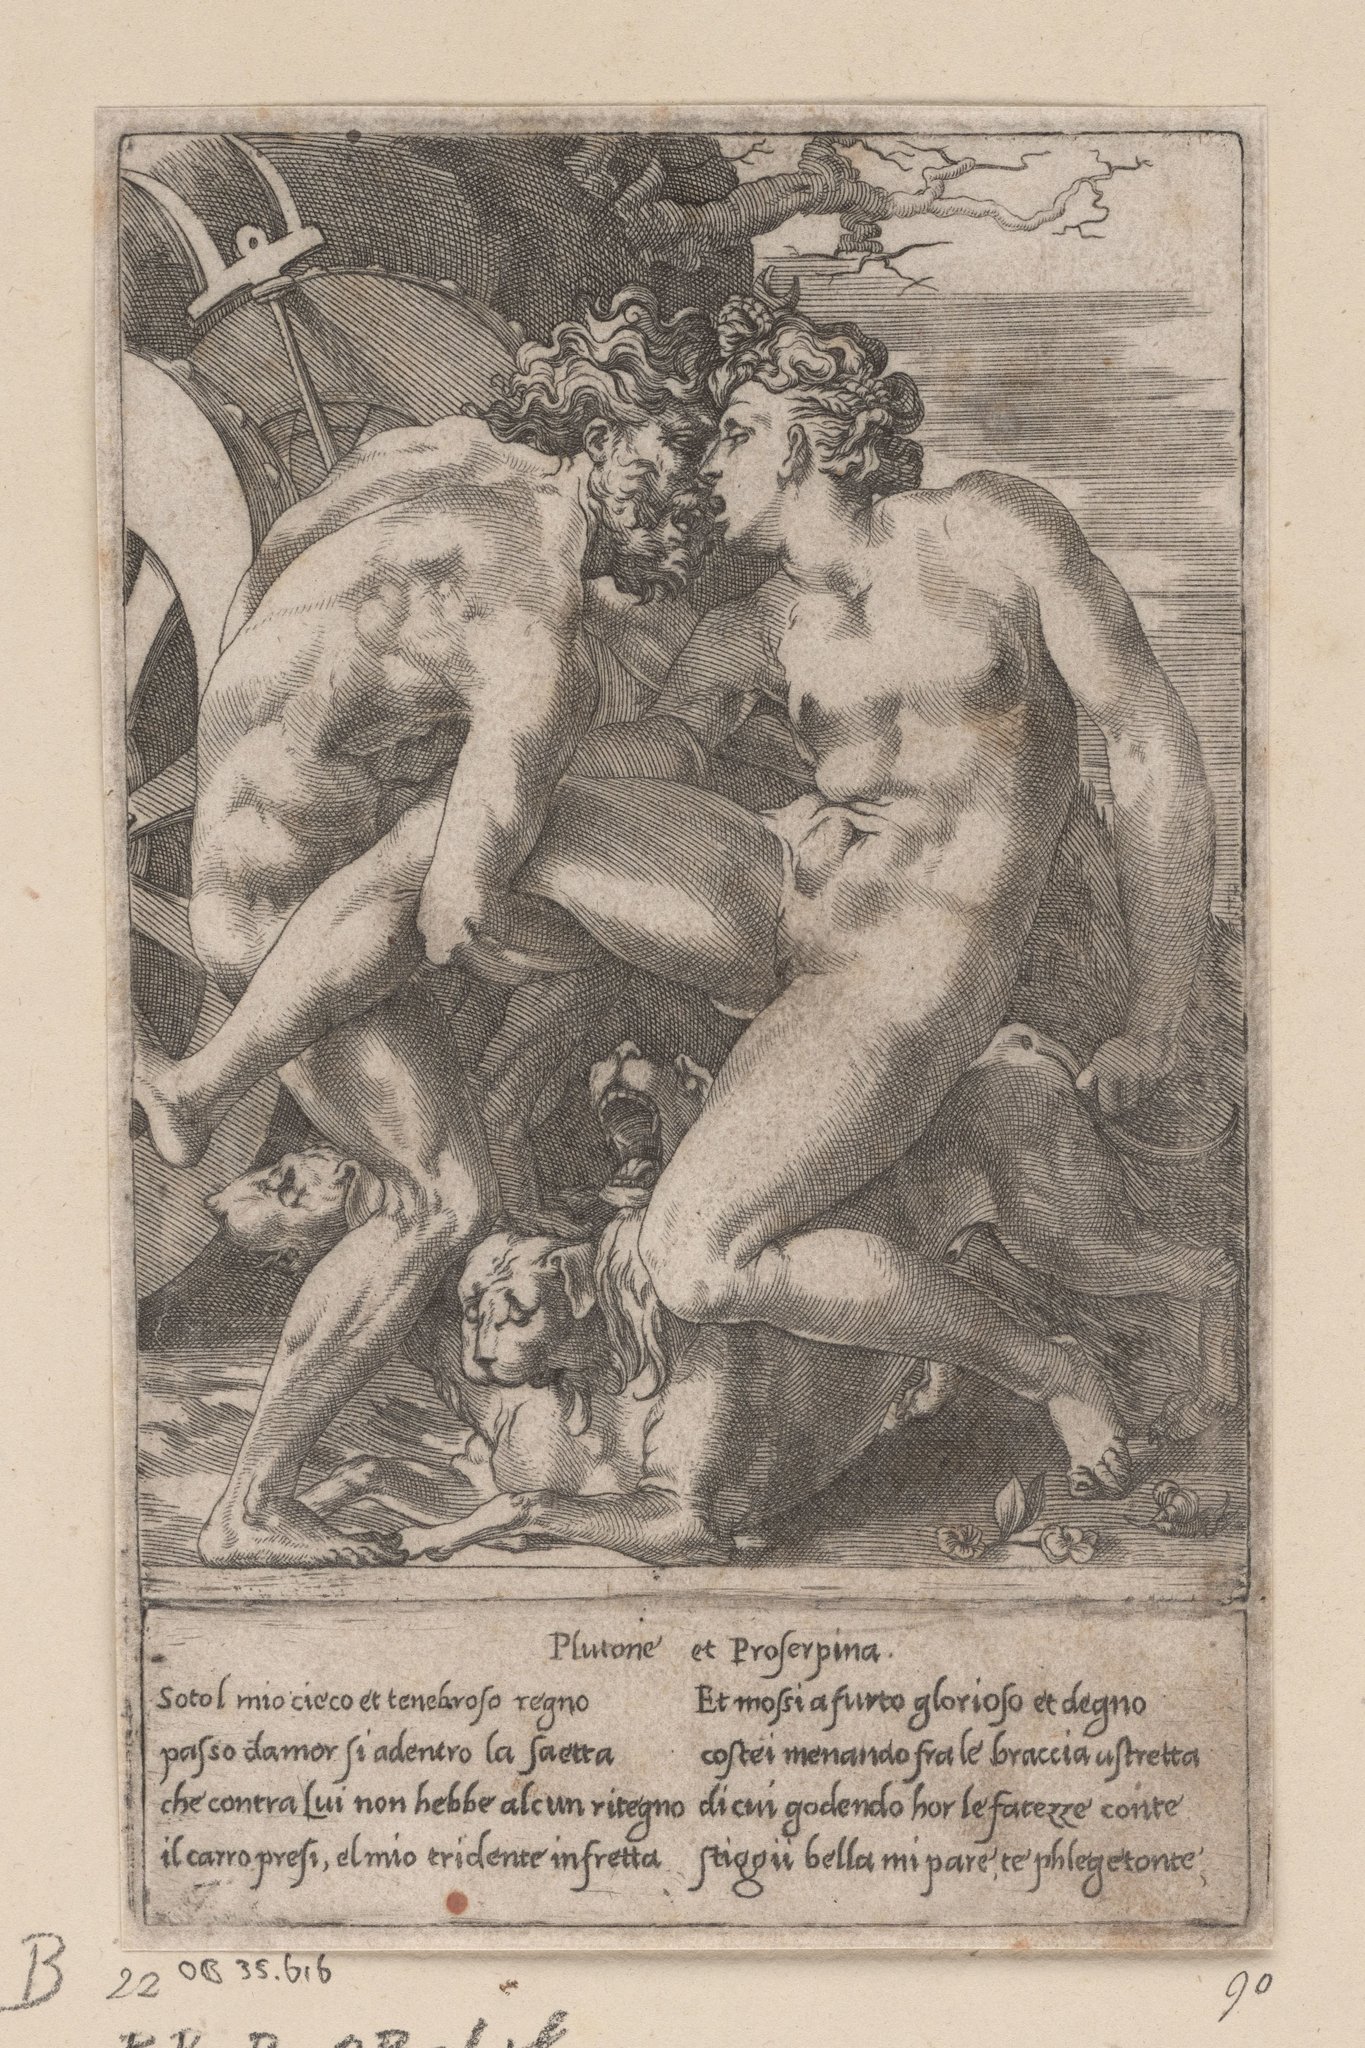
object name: print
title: Loves of the Gods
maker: giovanni jacopo caraglio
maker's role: goldsmith, print maker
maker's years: 1500-1565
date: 1515-1565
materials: paper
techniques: engraving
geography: italy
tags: love-affairs of pluto, pluto in love with proserpina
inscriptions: collector's mark: Lugt 240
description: No collection of erotic prints should be without Caraglio’s Loves of the Gods. Consisting of twenty-some prints, this scandalous series presents the amorous escapades of the classical gods fairly explicitly. The deities give in to pure lust with great abandon, which involves quite some acrobatic feats. These scenes will doubtless have titillated many a viewer.